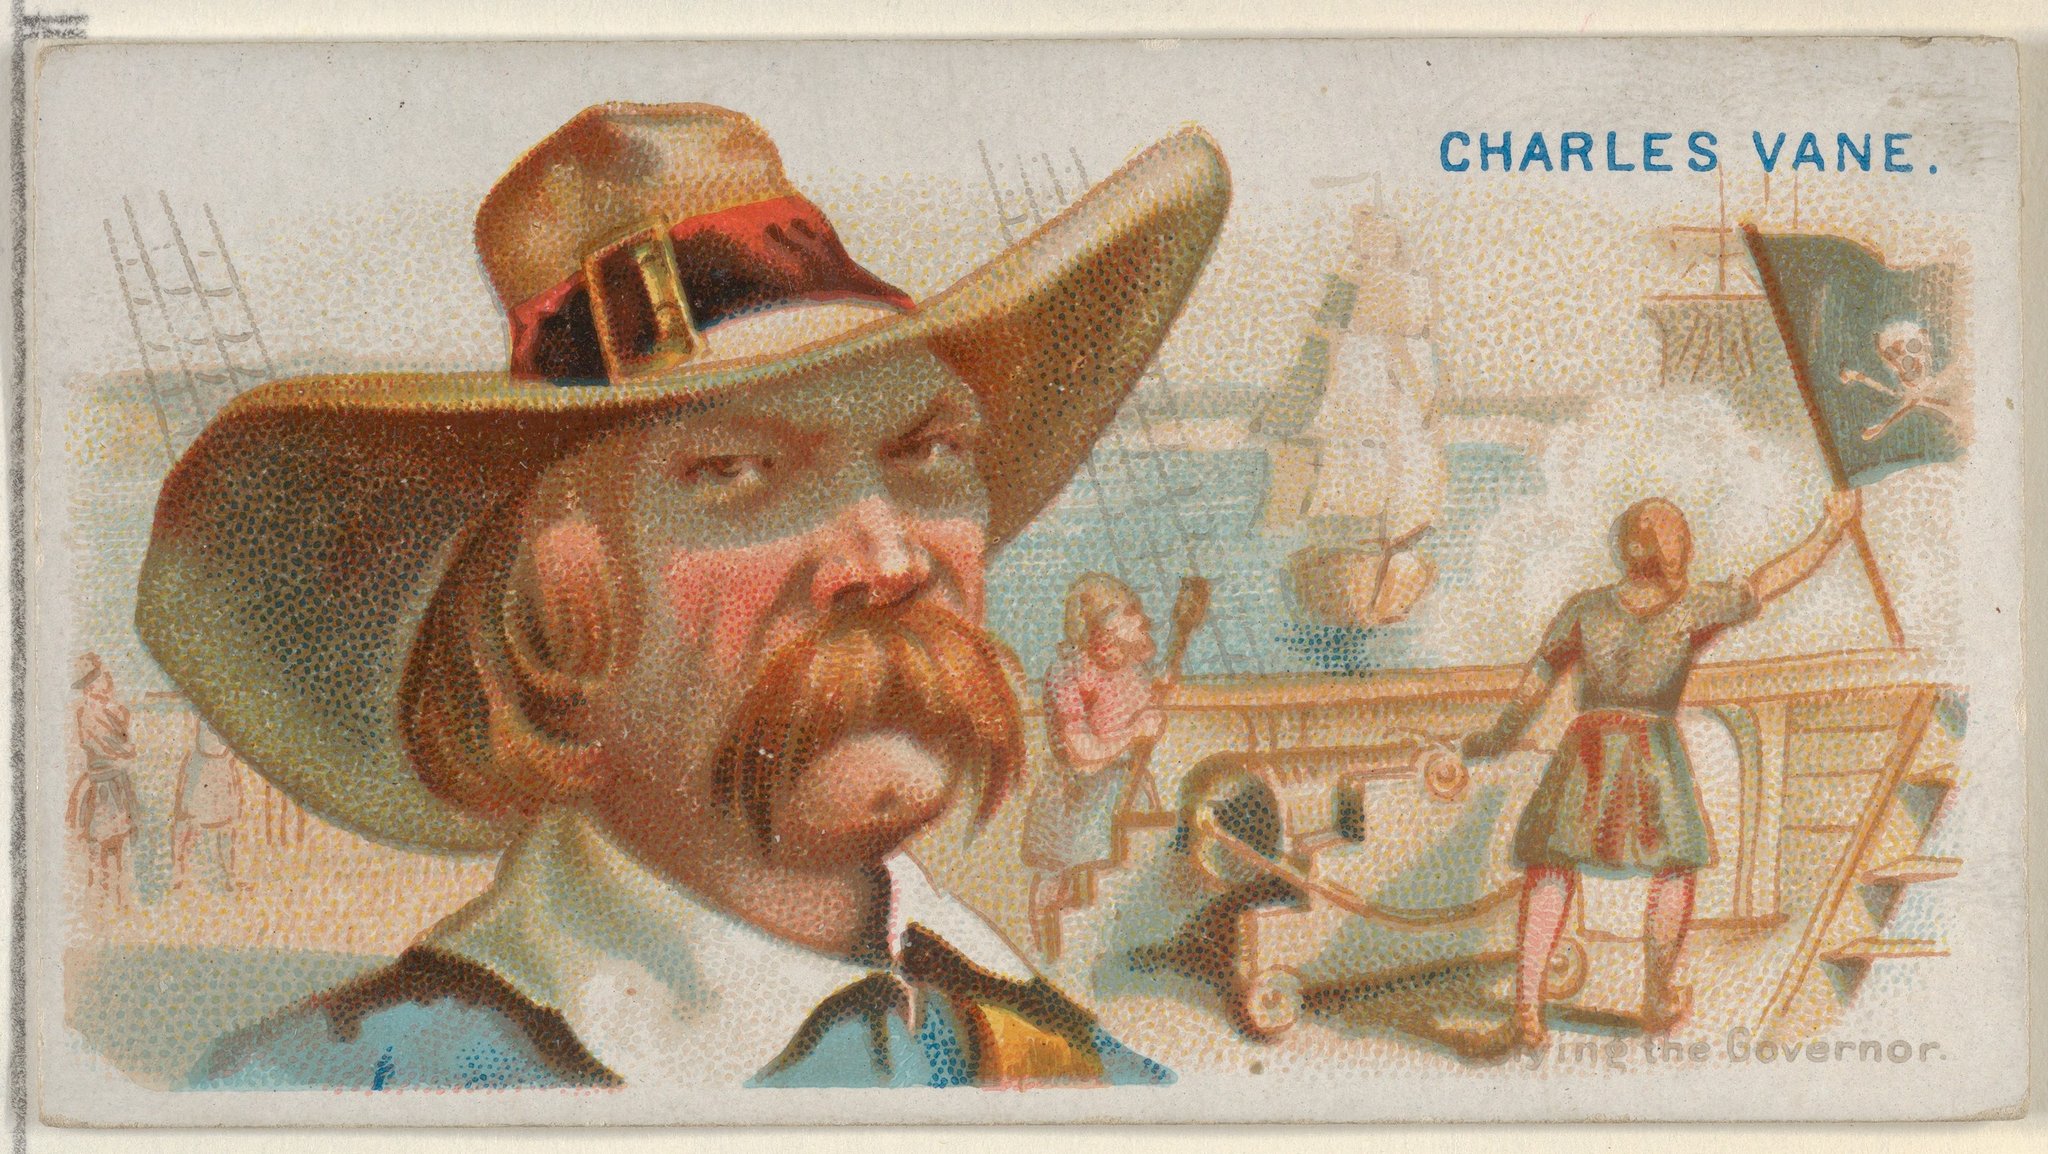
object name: print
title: Charles Vane, Defying the Governor, from the Pirates of the Spanish Main series (N19) for Allen & Ginter Cigarettes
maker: allen & ginter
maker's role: publisher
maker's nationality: american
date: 1888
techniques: color lithograph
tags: men,sailors,ships